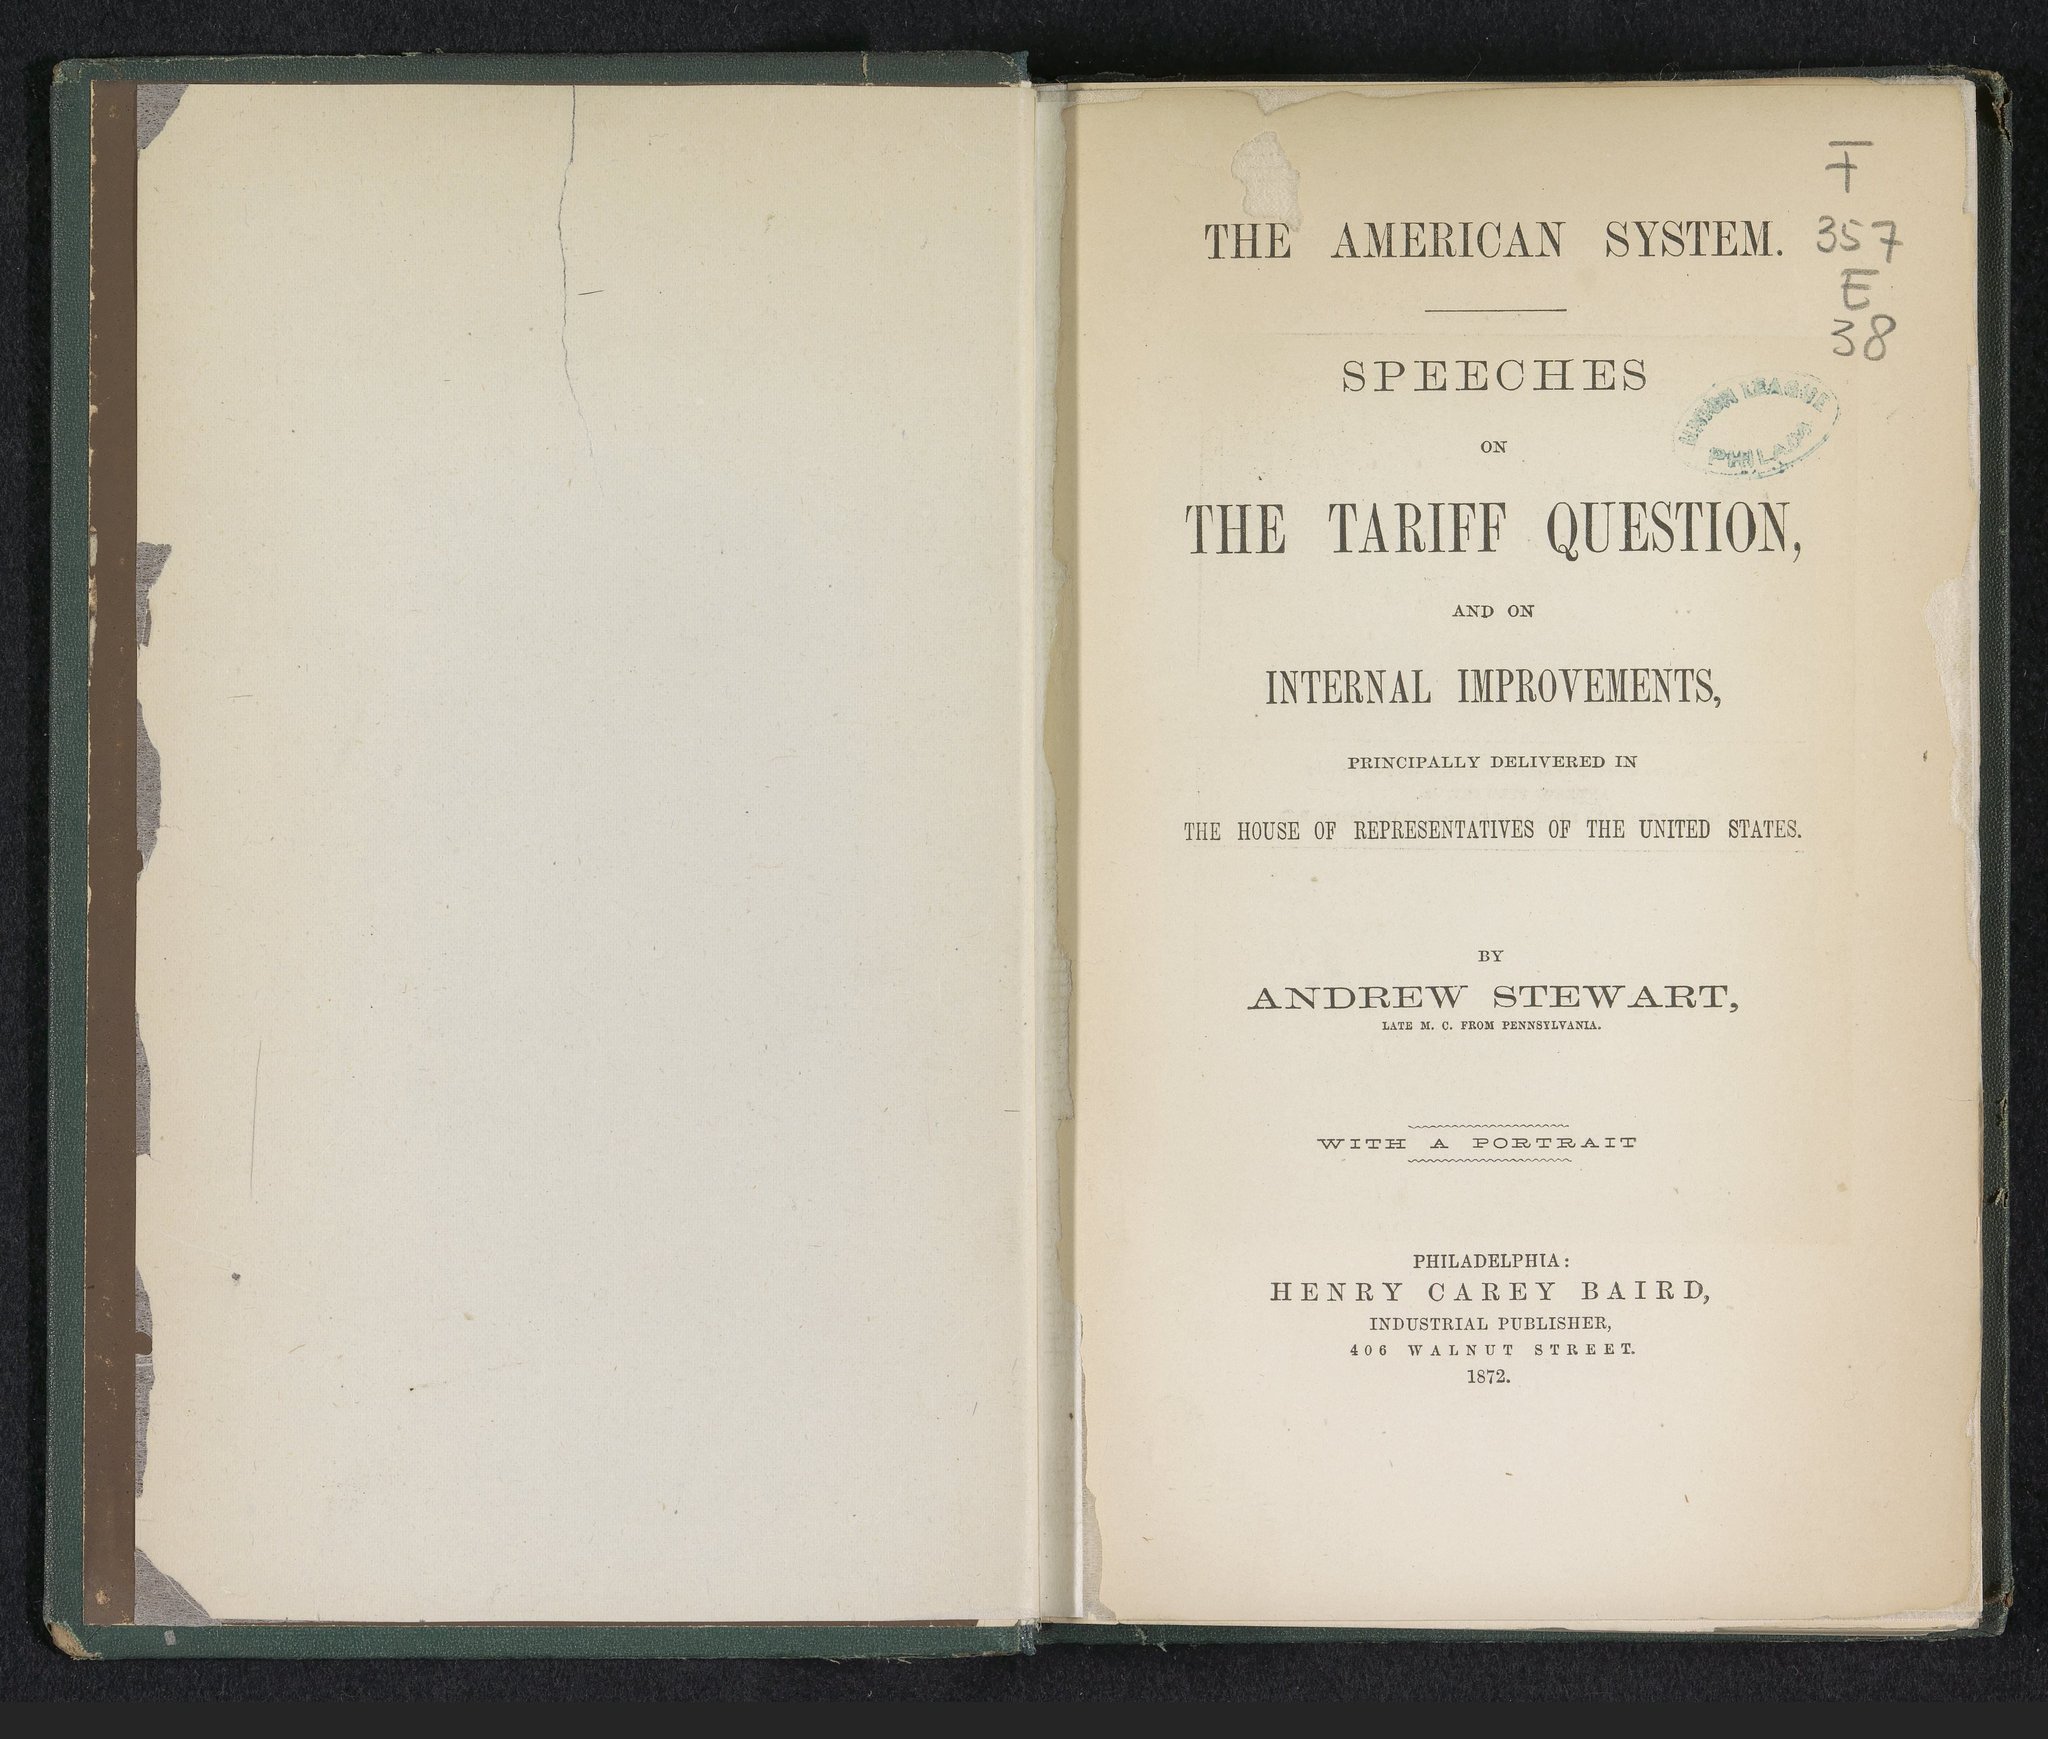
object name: book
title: The American system. Speeches on the tarif question and on improvements, principally delivered in the House of Representatives of the United States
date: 1872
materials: cardboard, linen, paper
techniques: printing, woodburytype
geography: philadelphia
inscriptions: inscription: ‘Union League Philadelphia Class, 337 No. 1’